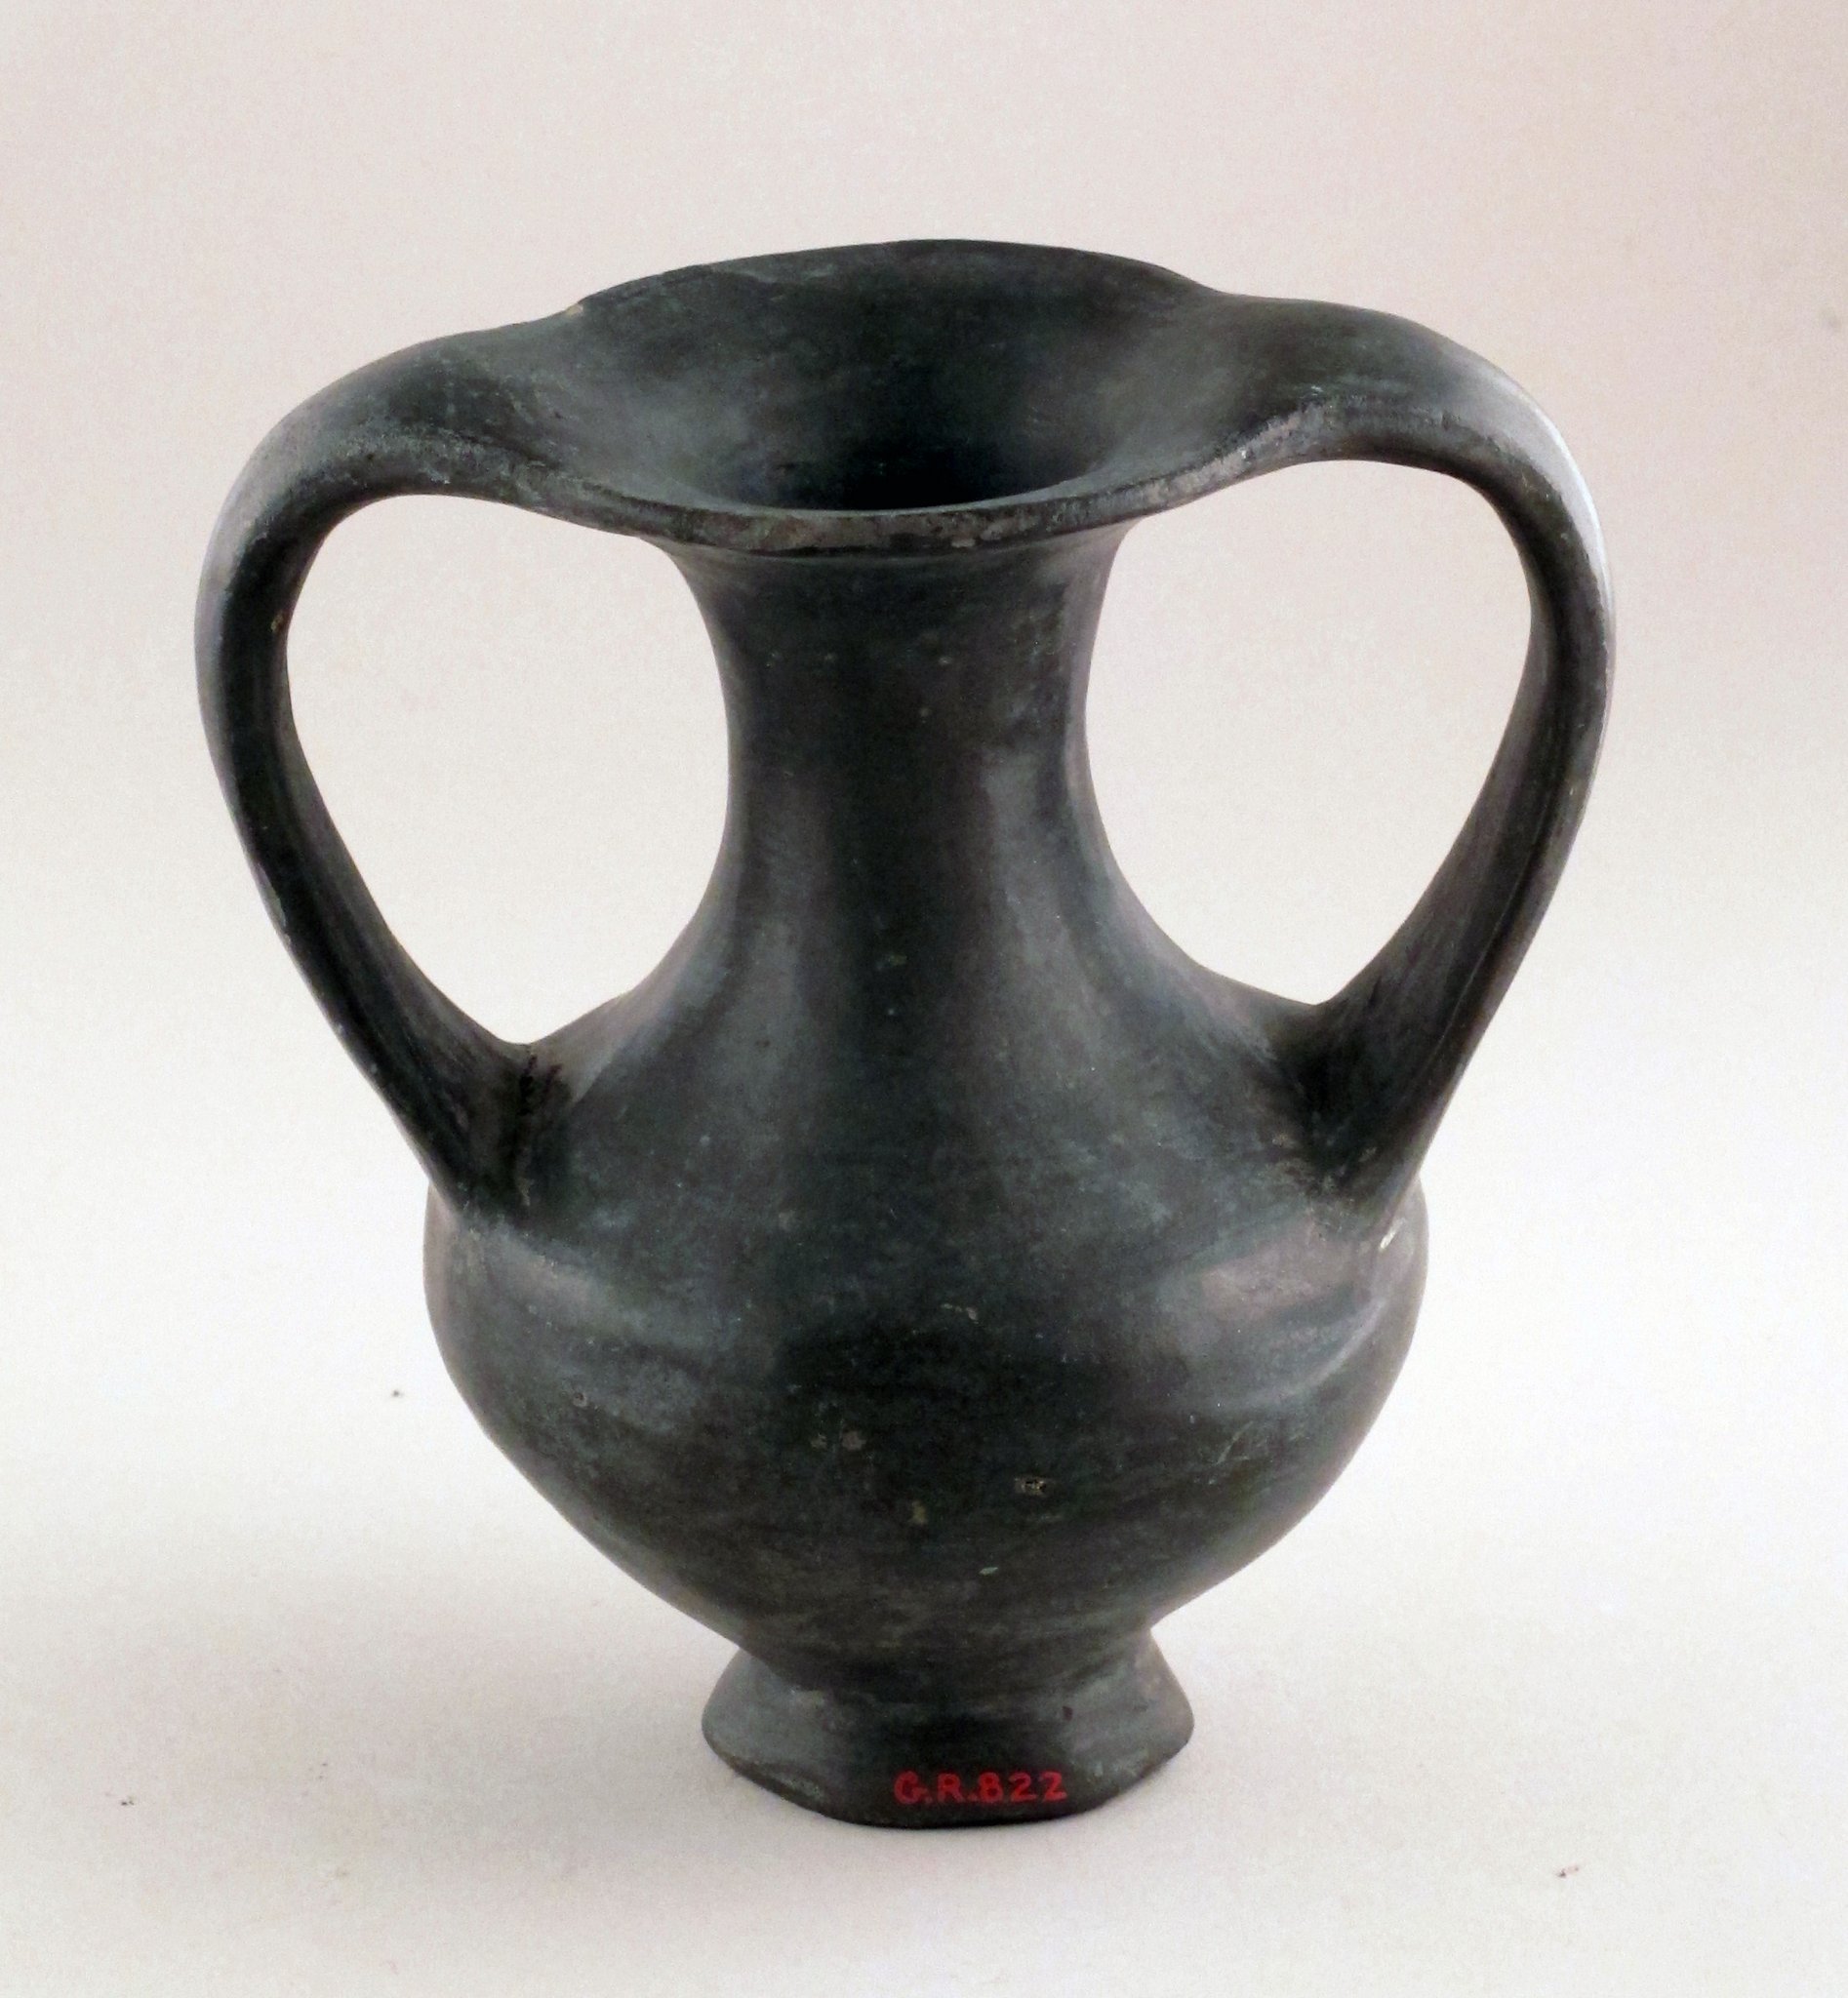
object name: jug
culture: etruscan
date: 634-501 BCE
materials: terracotta